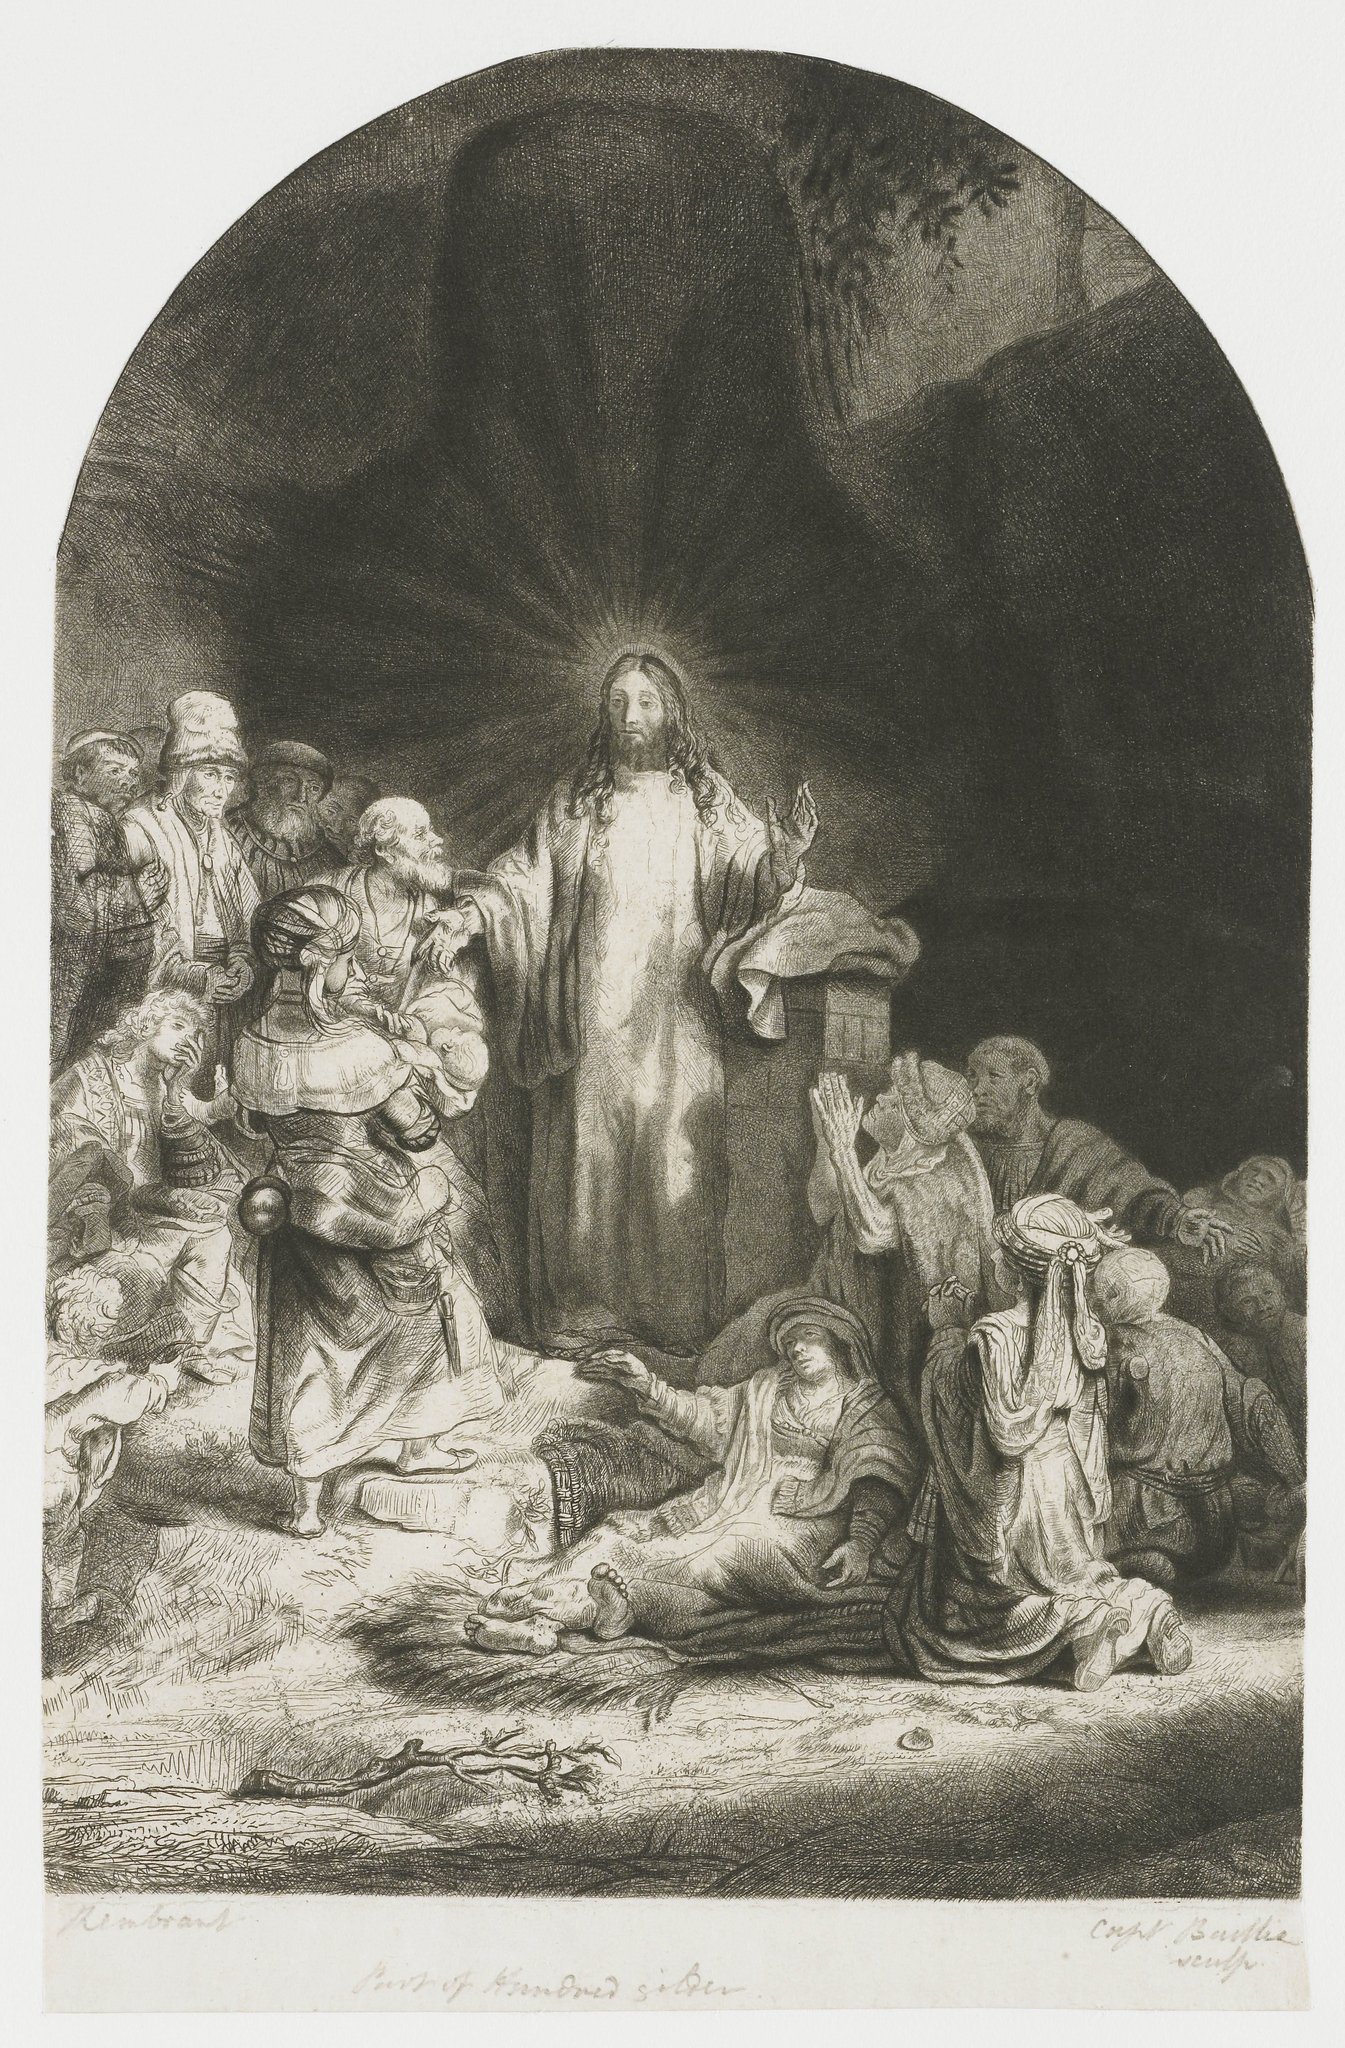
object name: print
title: The Hundred Guilder Print: the central piece with Christ preaching, the plate arched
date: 1775-1800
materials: paper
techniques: drypoint, etching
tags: christ preaching in the open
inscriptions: inscription: ‘Rembrant Part of Hundred Gilder Capt Baillie / sculp’, inscription: ‘C. 15195’, mark: Lugt 2228